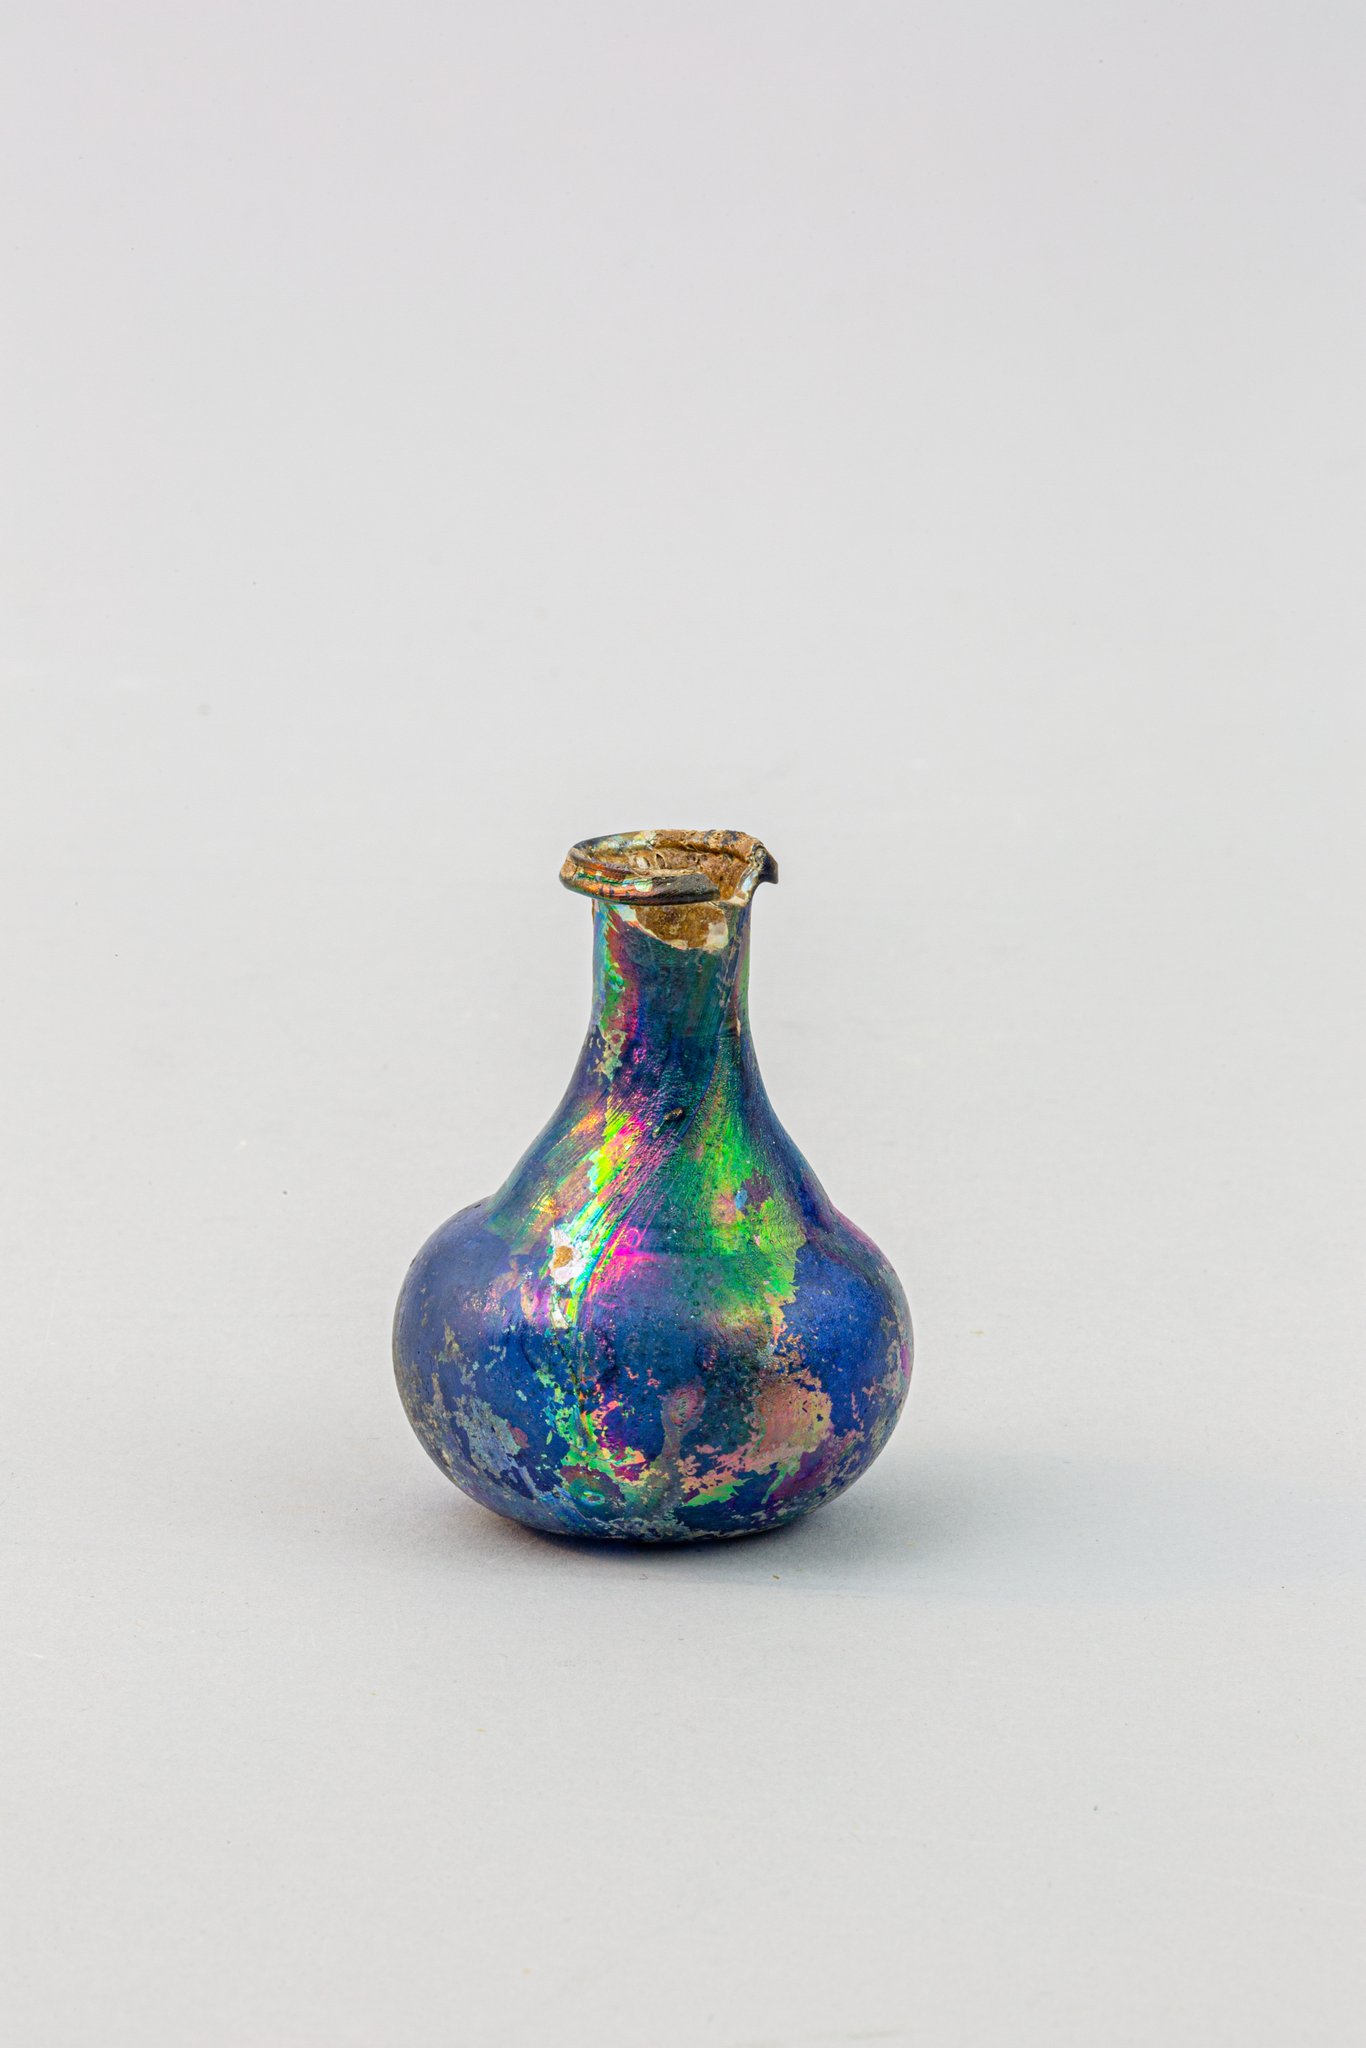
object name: perfume bottle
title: Glass perfume bottle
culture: roman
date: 1-100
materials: glass